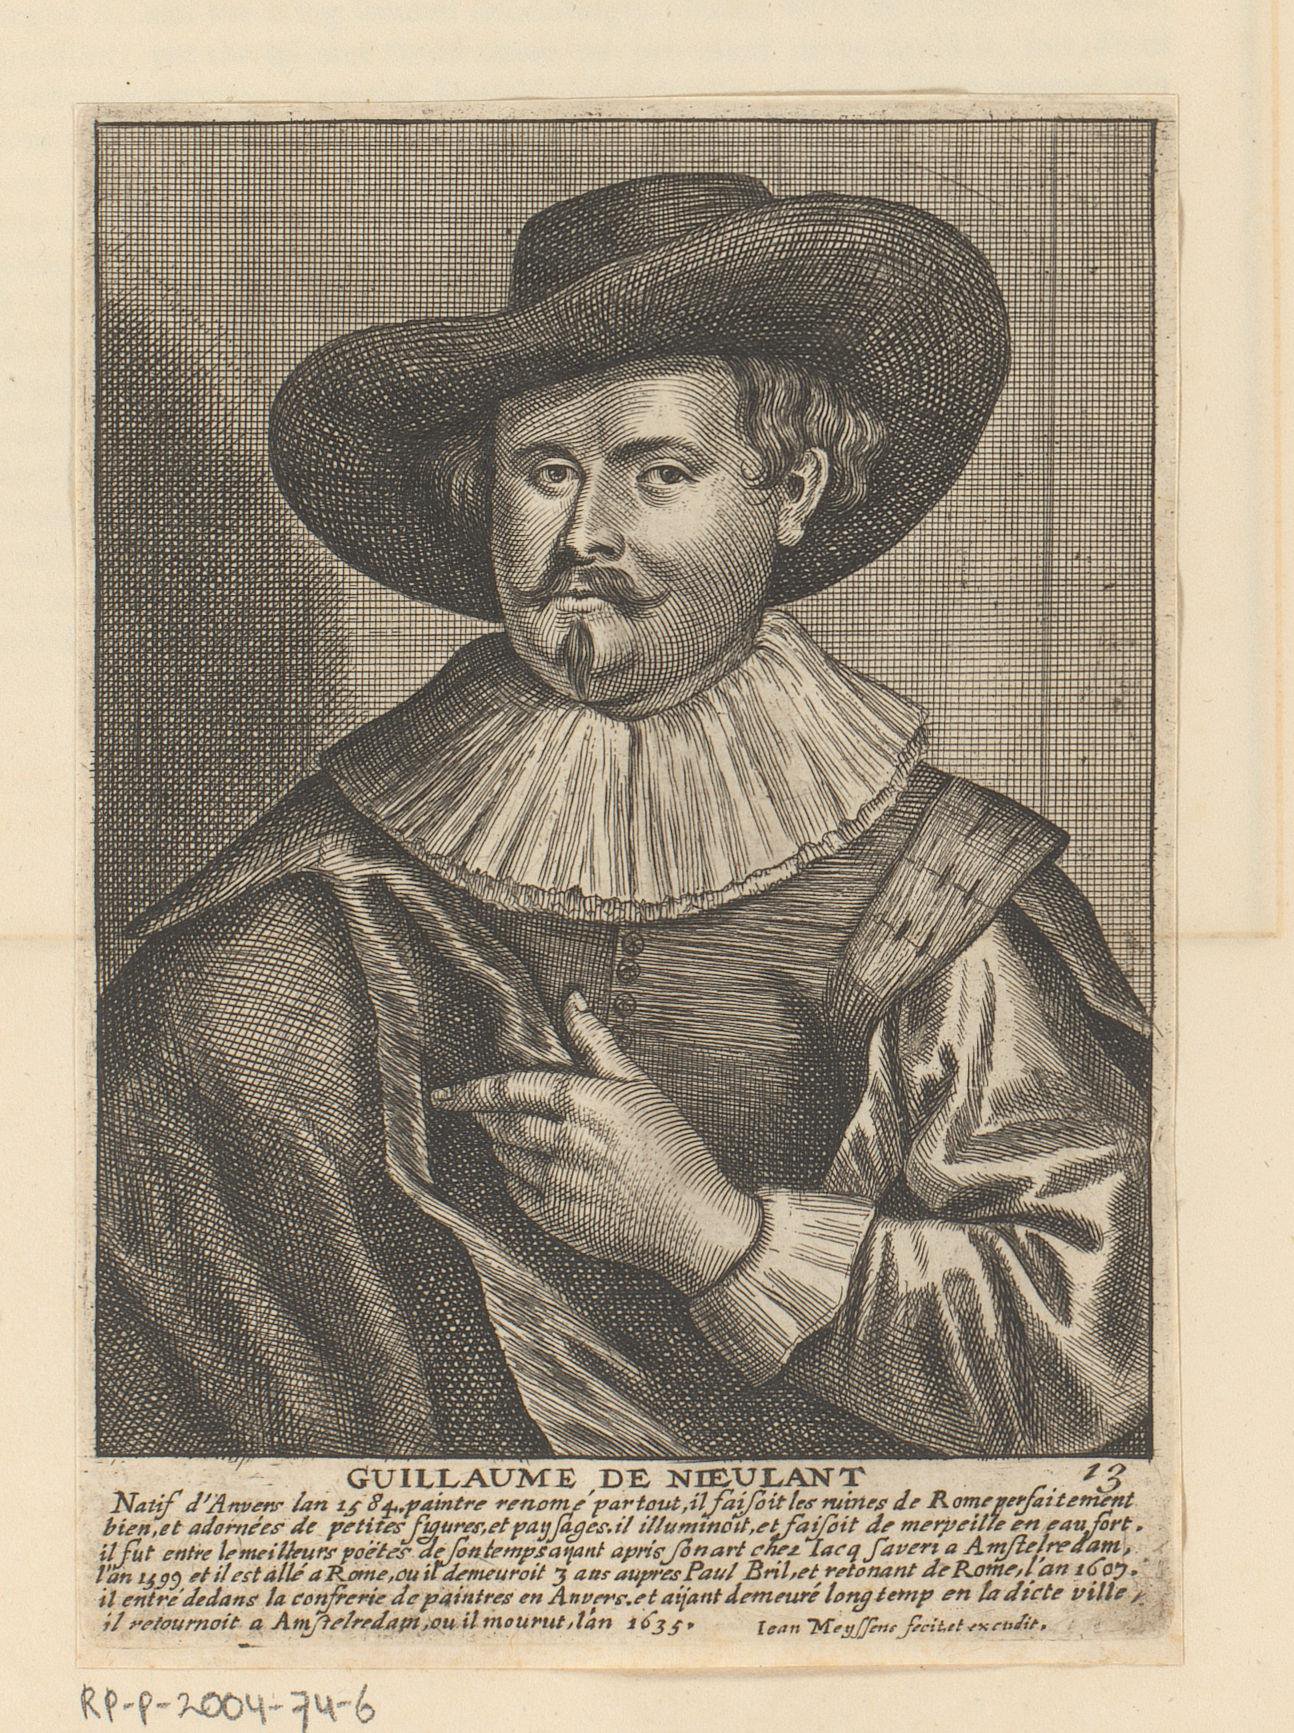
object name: album leaf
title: Guillaume De Nieulant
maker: joannes meyssens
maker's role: print maker, publisher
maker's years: 1612-1670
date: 1649-1662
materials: paper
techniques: engraving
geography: antwerp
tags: antwerp, amsterdam, print maker, draughtsman, guilliam van nieulandt (ii), historical persons, portrait, self-portrait of painter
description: Prent mogelijk uit: Meyssens, Joannes. Image de divers hommes desprit sublime qui par leur art et science deburovent vivre eternellement et des quels la louange et renommée faict estonner le monde. 2 dln. Antwerpen: Joannes Meyssens, 1649, dl. 1, p. 32. Andere staat van prent gebruikt in: Bie, Cornelis De. Het gulden Cabinet vande edel vry schilder const, inhoudende den lof vande vermarste schilders, architecte, beldthowers ende plaetsnyders van dese eeuw. Antwerpen: Joannes Meyssens, 1662 [1661 foutief op titelpagina], p. 63. Deze staat heeft boekdruk op verso. De samensteller heeft deze prent in het album geplakt als illustratie bij: Pilkington, Matthew en Johann Heinrich Füssli. A dictionary of painters, from the revival of the art to the present period. 4 dln. Londen: John Crowder, 1805, dl. 3, p. 365.